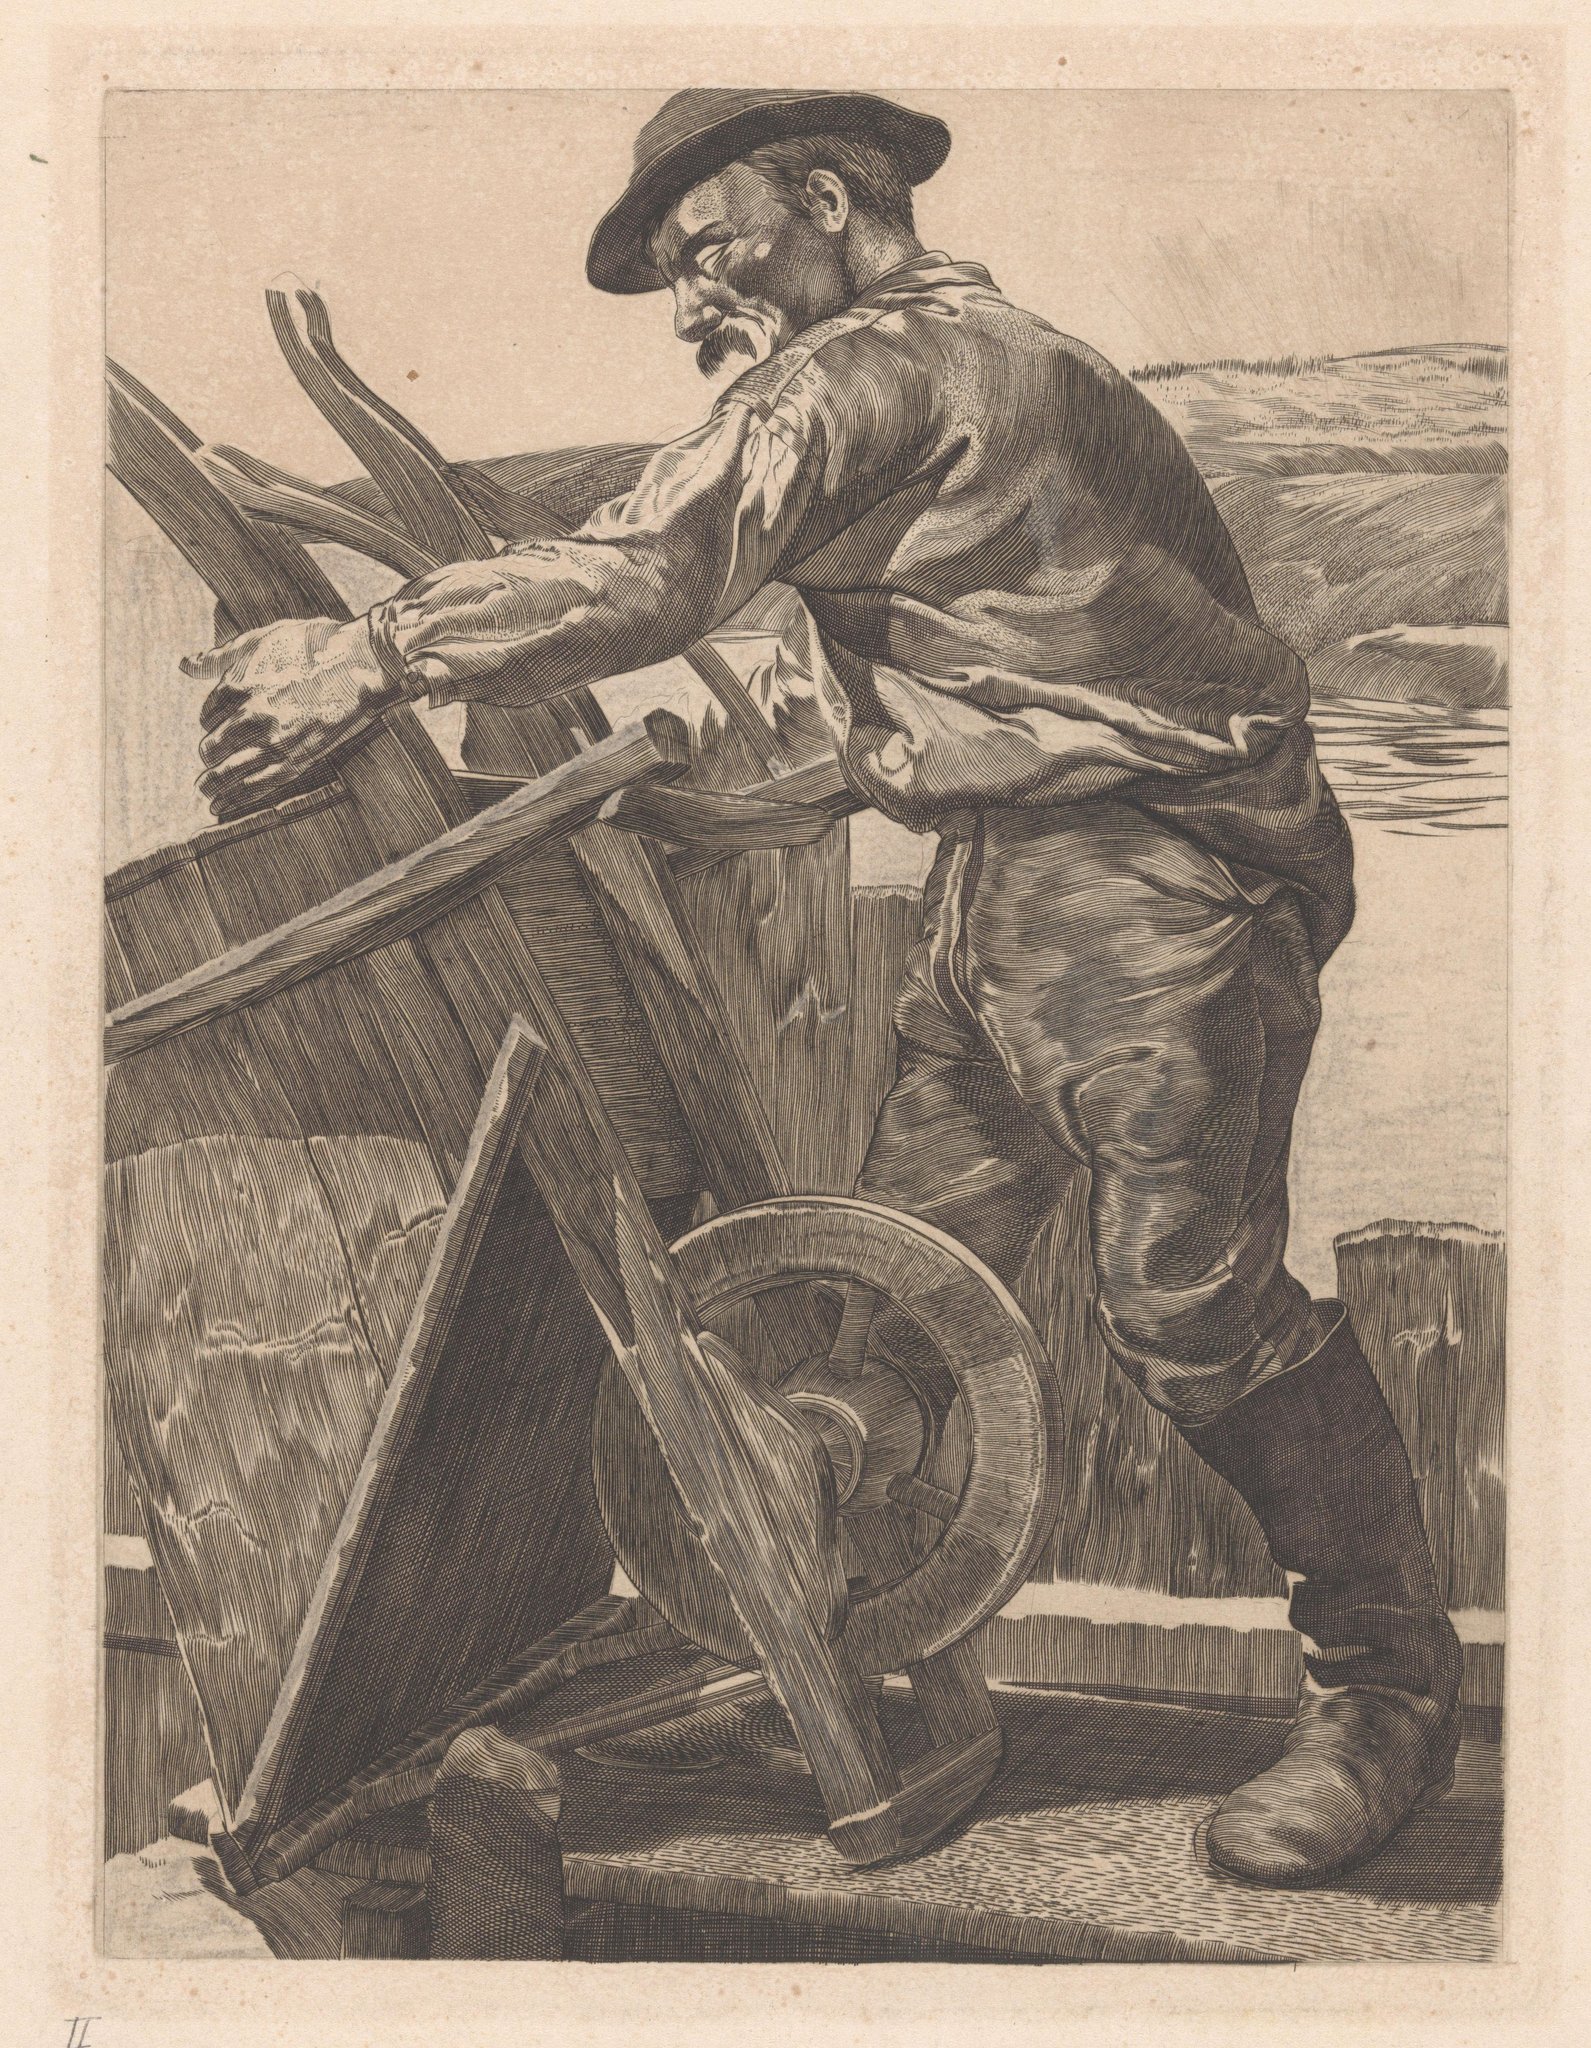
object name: print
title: Arbeider met een kruiwagen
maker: johannes josephus aarts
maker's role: draughtsman, print maker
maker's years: 1871-1934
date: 1881-1934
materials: chalk, paper, pencil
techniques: aquatint, engraving, intaglio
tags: working class, labourers, wheelbarrow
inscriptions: collector's mark: Lugt 2228, collector's mark: Lugt 2760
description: Een man met hoed keert een houten kruiwagen om. Op de achtergrond water en heuvels.